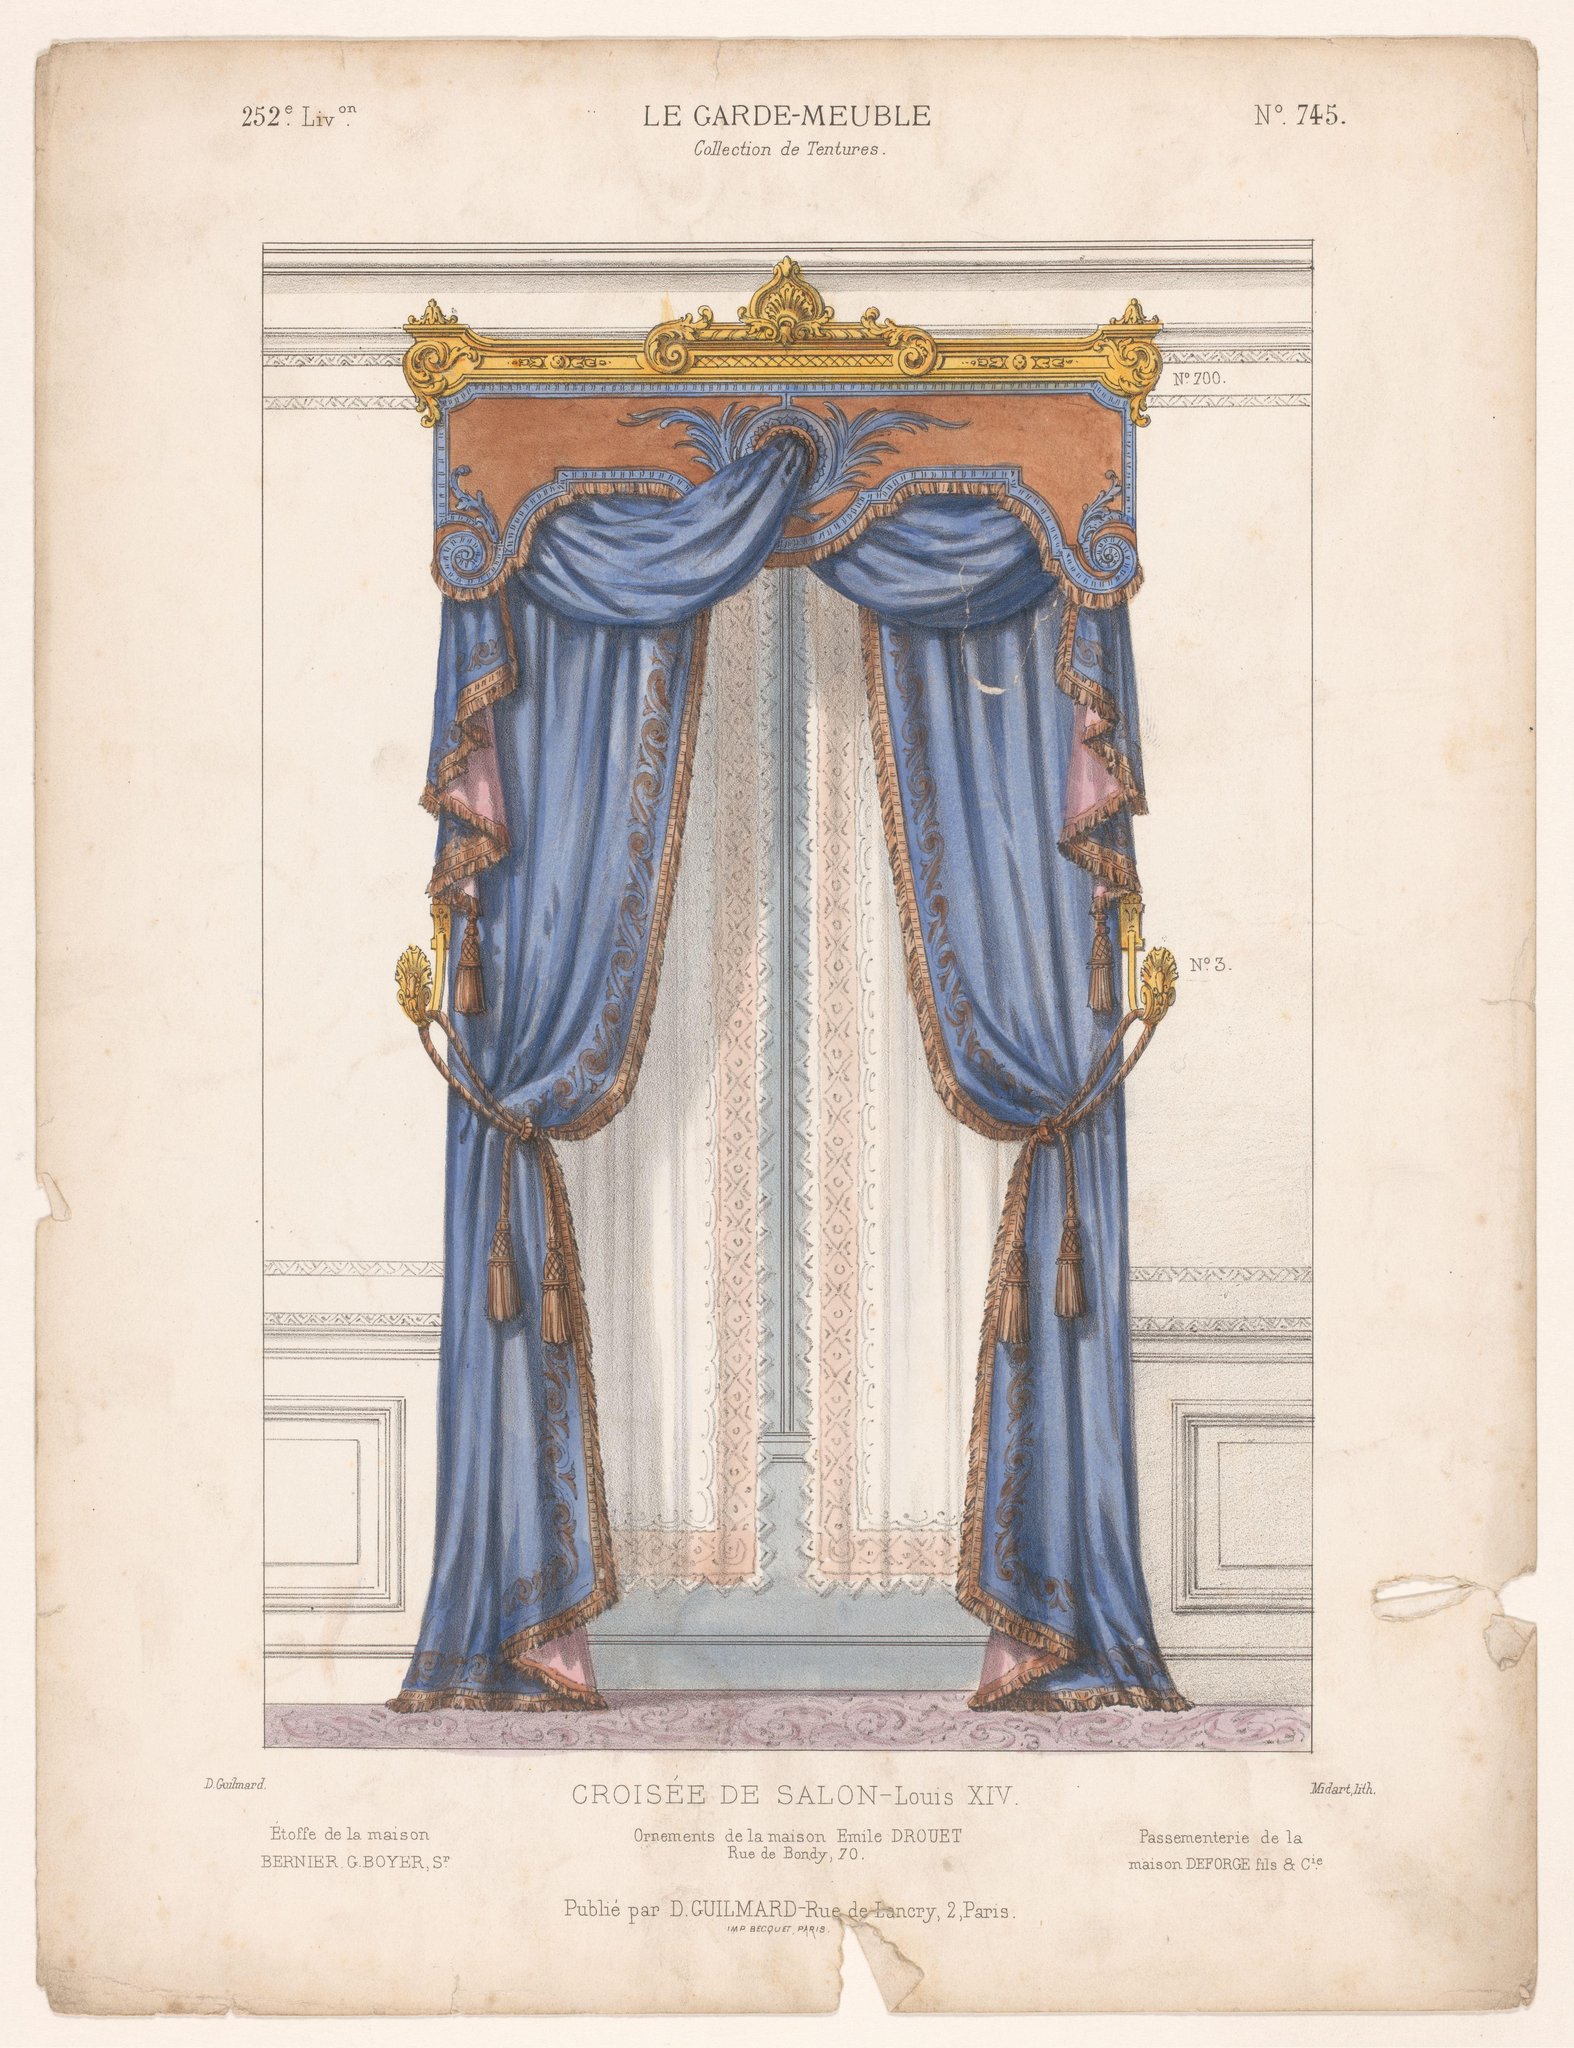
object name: print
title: Croisée de Salon - Louis XIV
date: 1860-1880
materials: paper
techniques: hand coloring, lithograph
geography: paris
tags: window, hangings and drapery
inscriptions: annotation: ‘3930 [...]’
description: Salonvenster met gedrapeerde gordijnen in de Lodewijk XIV-stijl. Prent uit 252e Livraison.